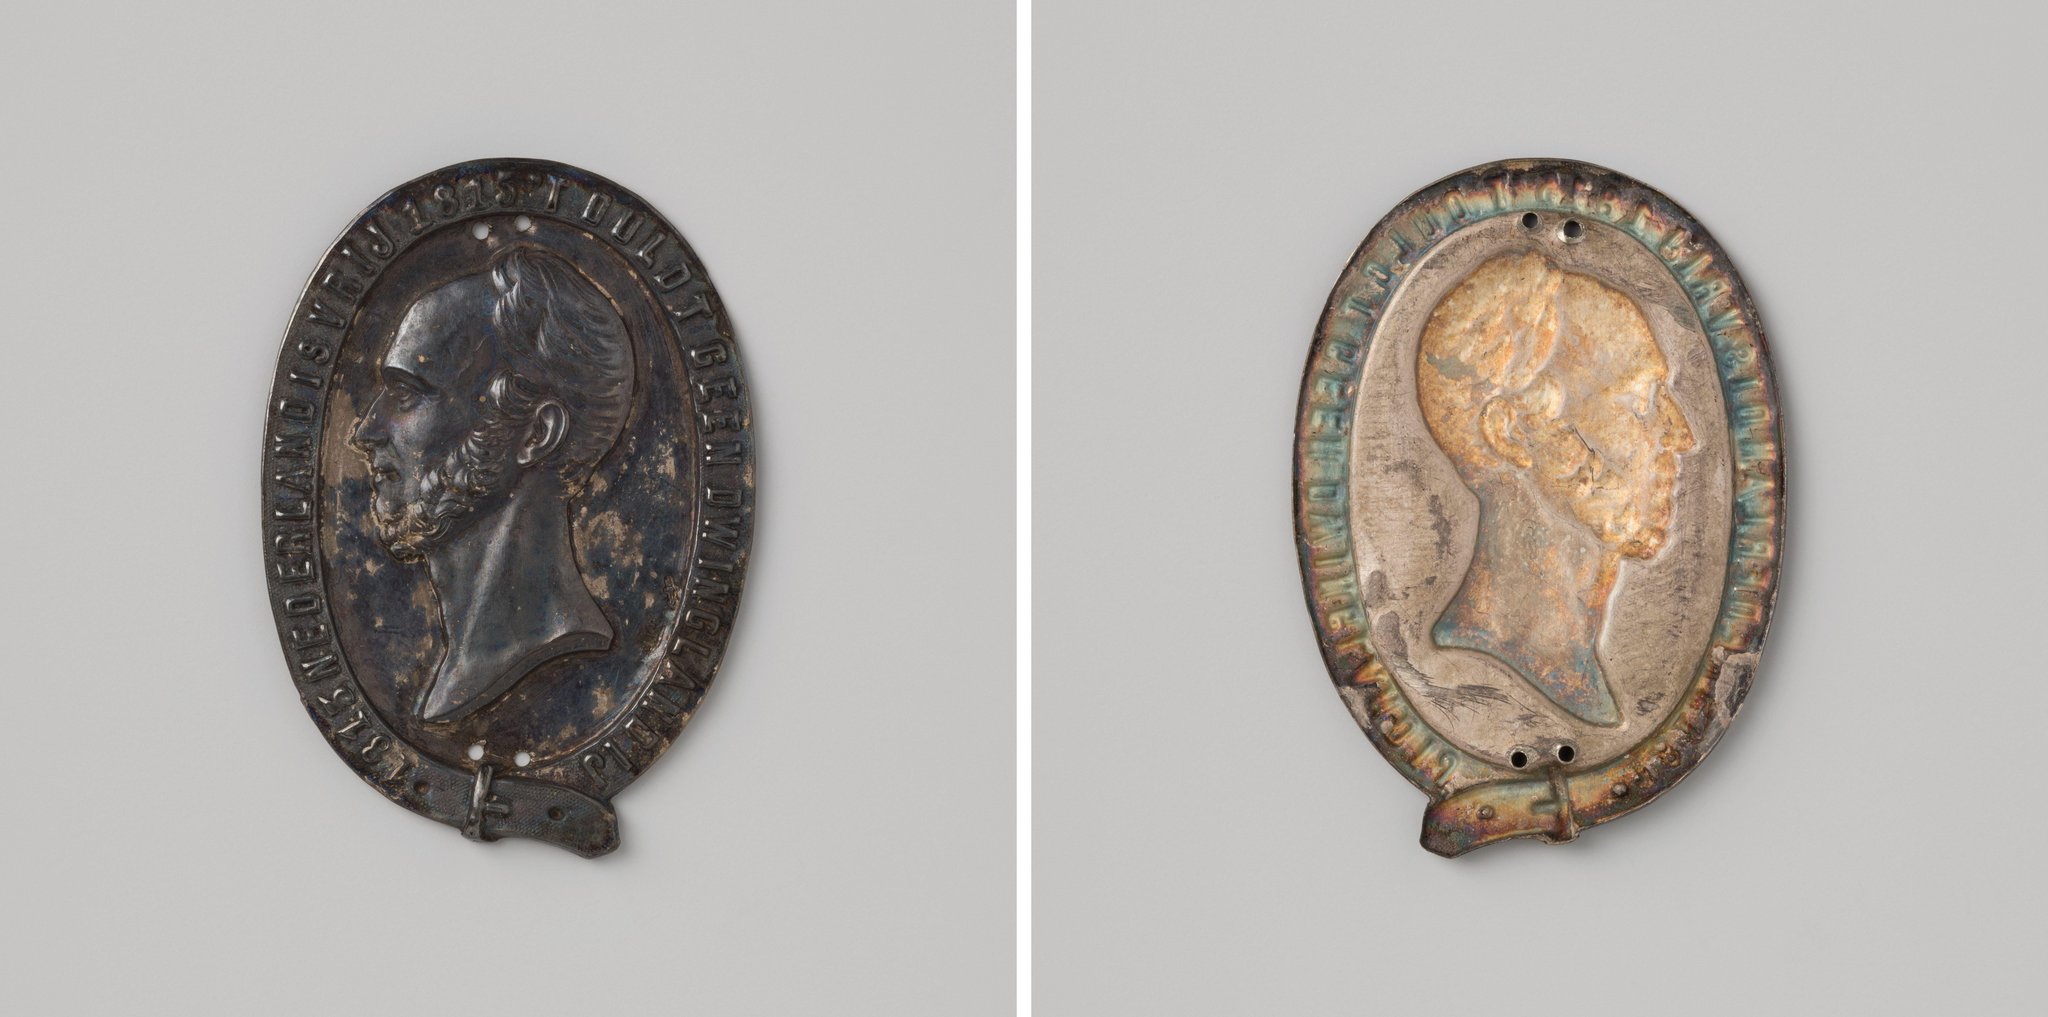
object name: insignia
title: Willem, erfprins der Nederlanden, op de bevrijding van Nederland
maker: david van der kellen (1804-1879)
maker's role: die cutter, draughtsman, print maker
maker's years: 1804-1879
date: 1815-1865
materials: silver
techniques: striking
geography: utrecht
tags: the hague, william ii of the netherlands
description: Eenzijdige zilveren ovale penning. Voorzijde: borststuk man binnen omschrift op riem, waarvan gedeelte van uiteinde uitsteekt uit vlak van penning. Keerzijde: blanco